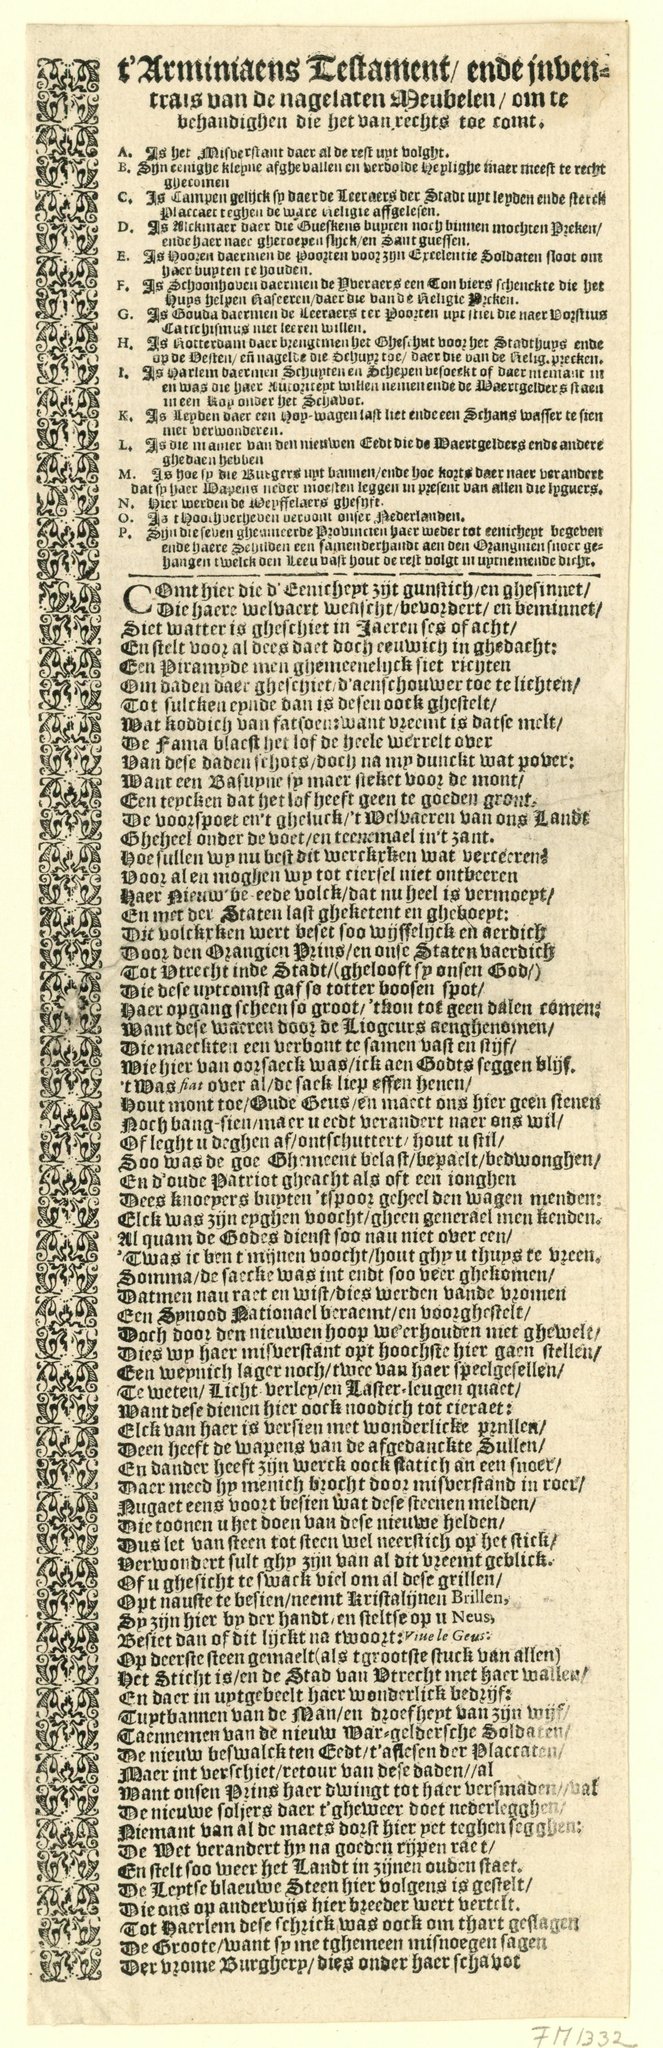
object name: text sheet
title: Tekst behorend bij de prent 't Arminiaens Testament, 1618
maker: Anonymous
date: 1618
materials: paper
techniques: letterpress printing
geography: northern netherlands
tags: remonstranten en contraremonstranten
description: Tekstblad behorend bij een uitgave van de prent van het Arminiaans Testament. Het eerste gedeelte is een legenda A-P, het tweede deel is een ingekorte versie van het vers behorend bij FMH 1329a. Aan de linkerzijde een decoratieve rand in houtsnede.